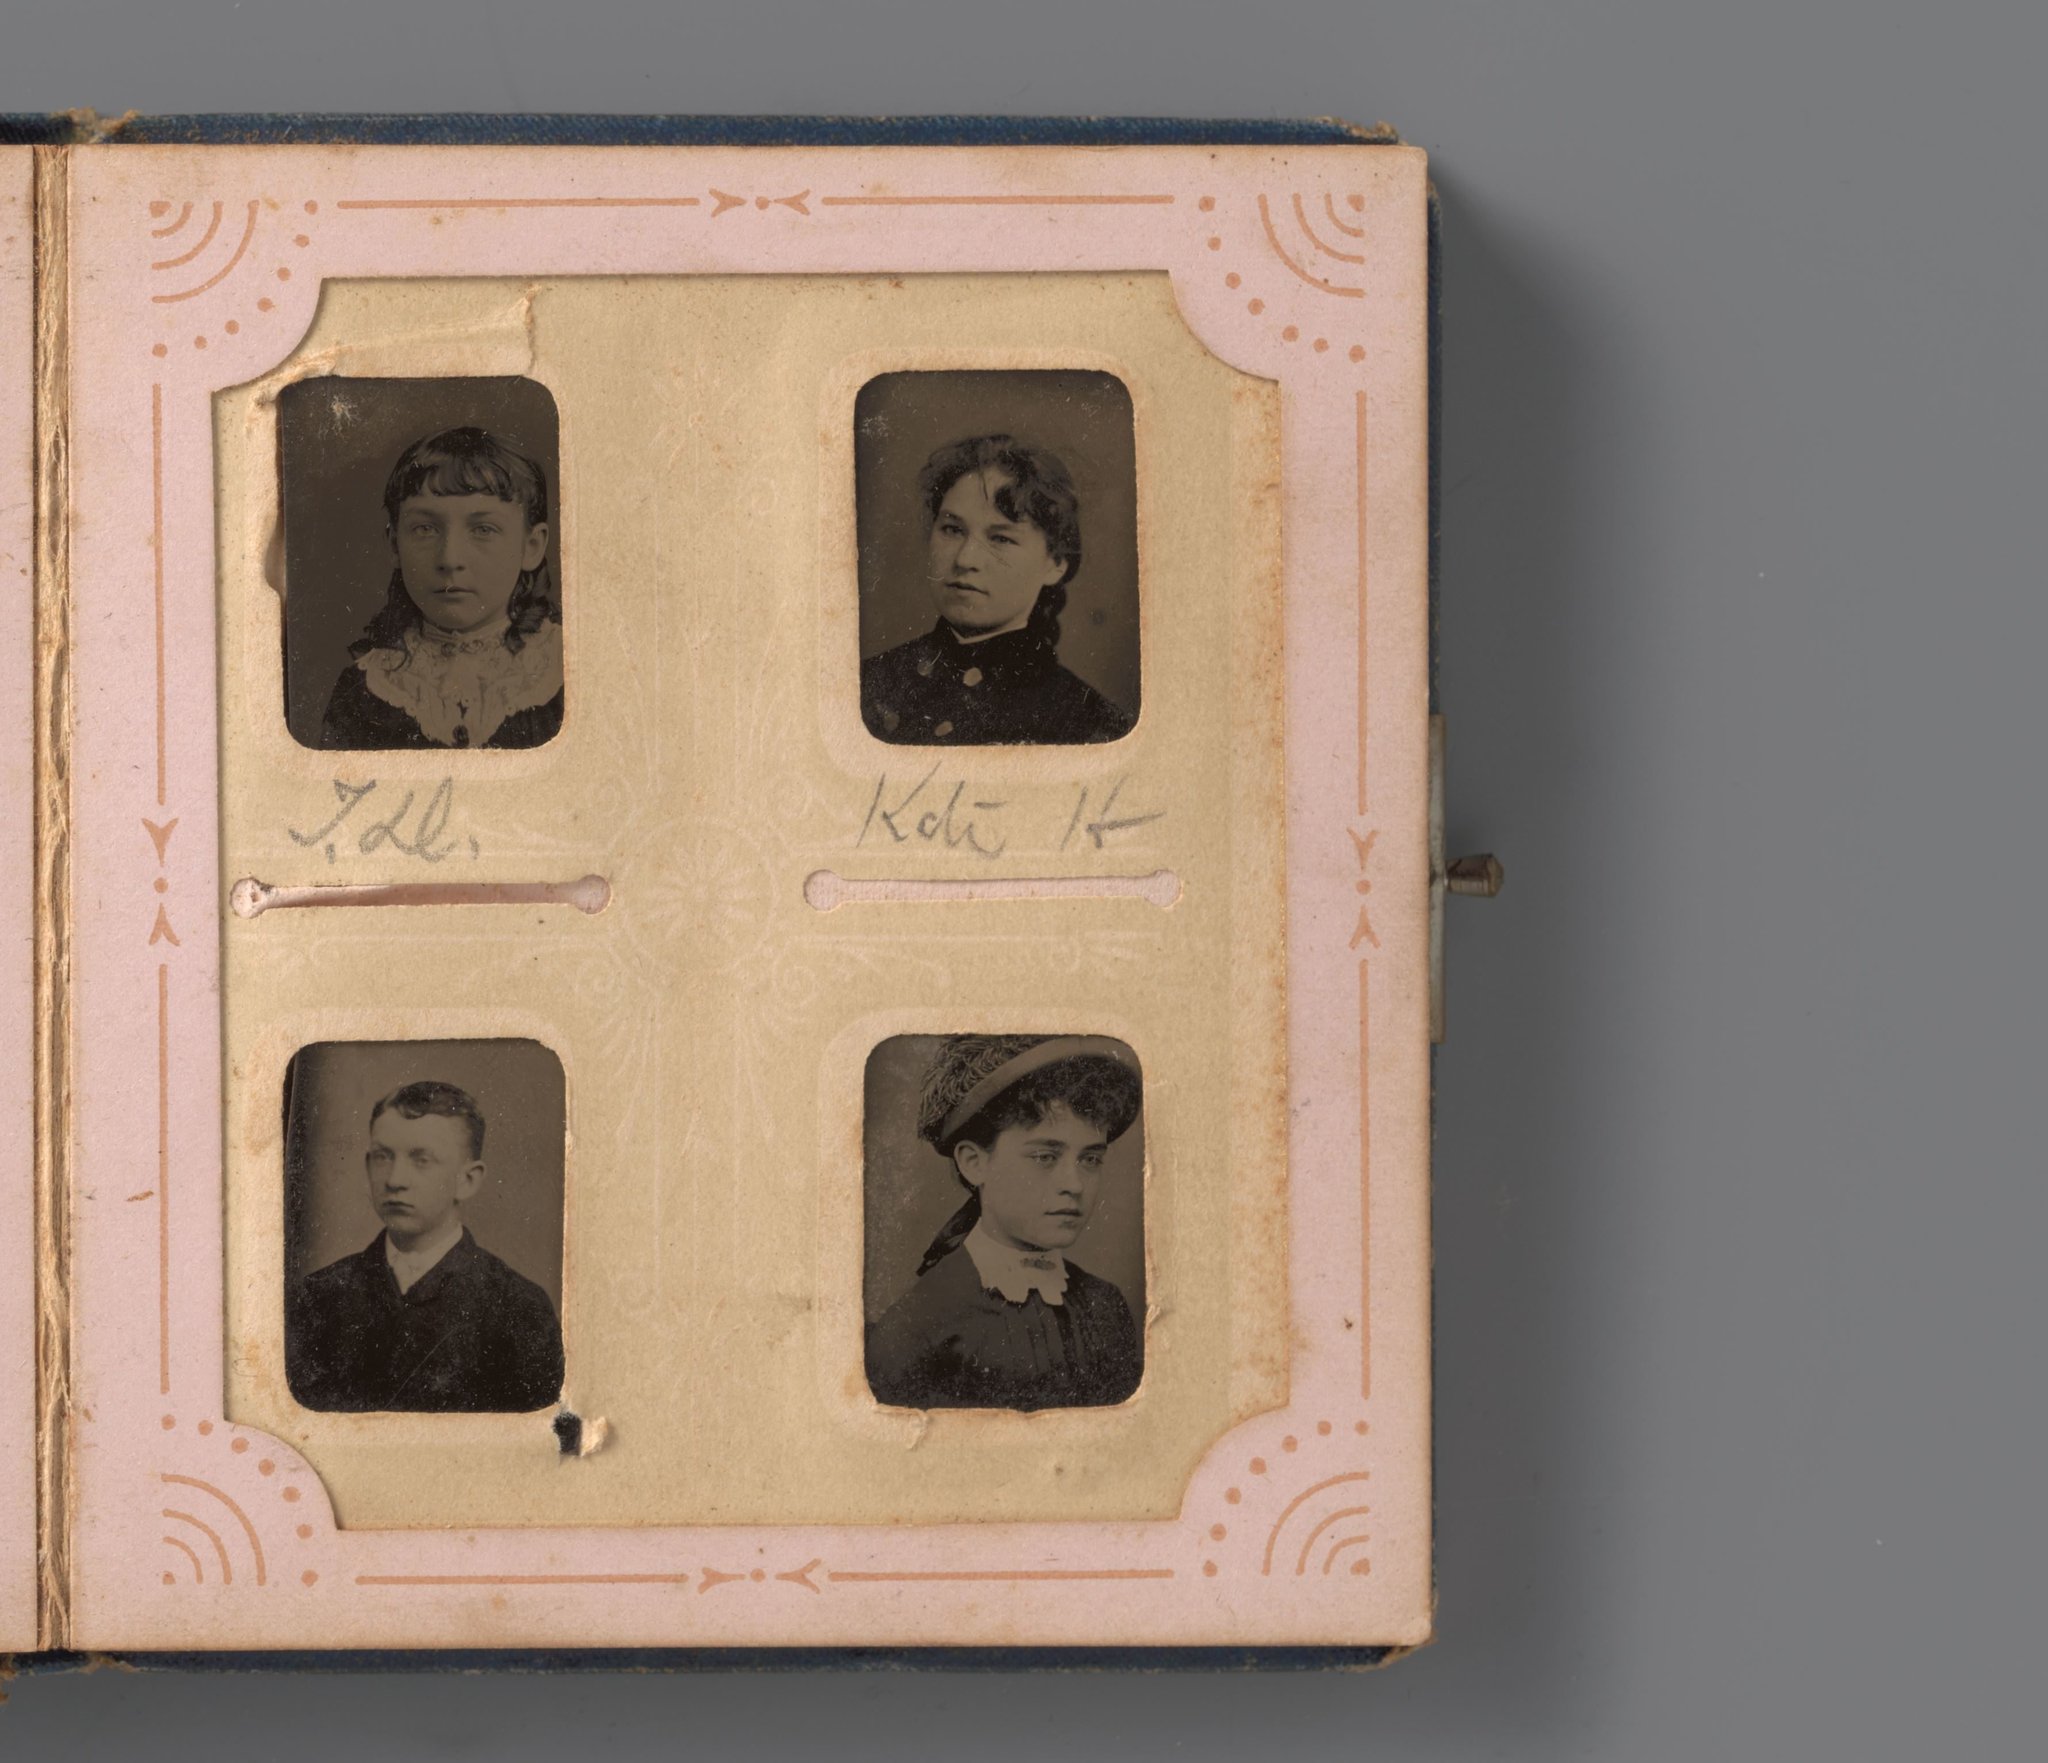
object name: album leaf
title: Vier portretten van jonge vrouwen en een jonge man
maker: Anonymous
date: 1855-1940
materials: cardboard, iron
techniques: ferrotyping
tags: adolescent, young woman, maiden, historical persons - bb - woman, historical persons, youth, adolescent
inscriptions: monogram: ‘Ka[t] [K]’, monogram: ‘I. [D]’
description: Deze foto's maken deel uit van een album.